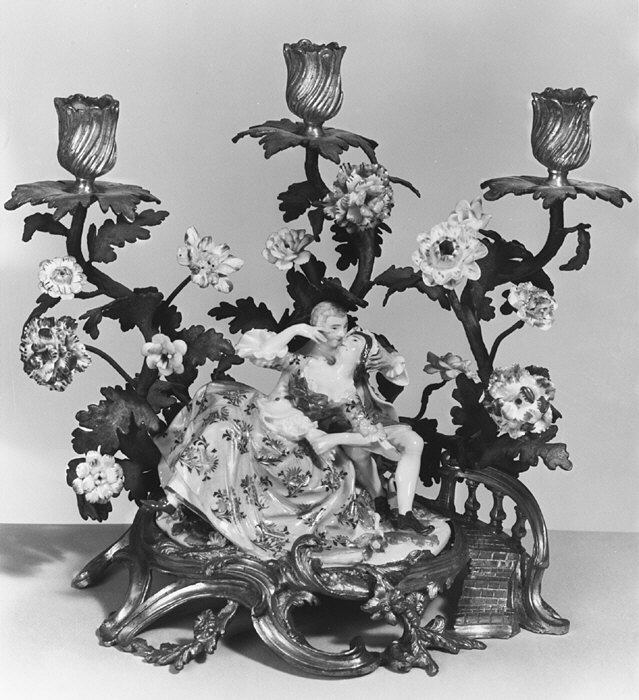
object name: candelabrum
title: Lovers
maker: meissen manufactory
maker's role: manufactory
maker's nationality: german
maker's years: 1710-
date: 1746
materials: gilt bronze, soft paste porcelain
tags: couples,men,women